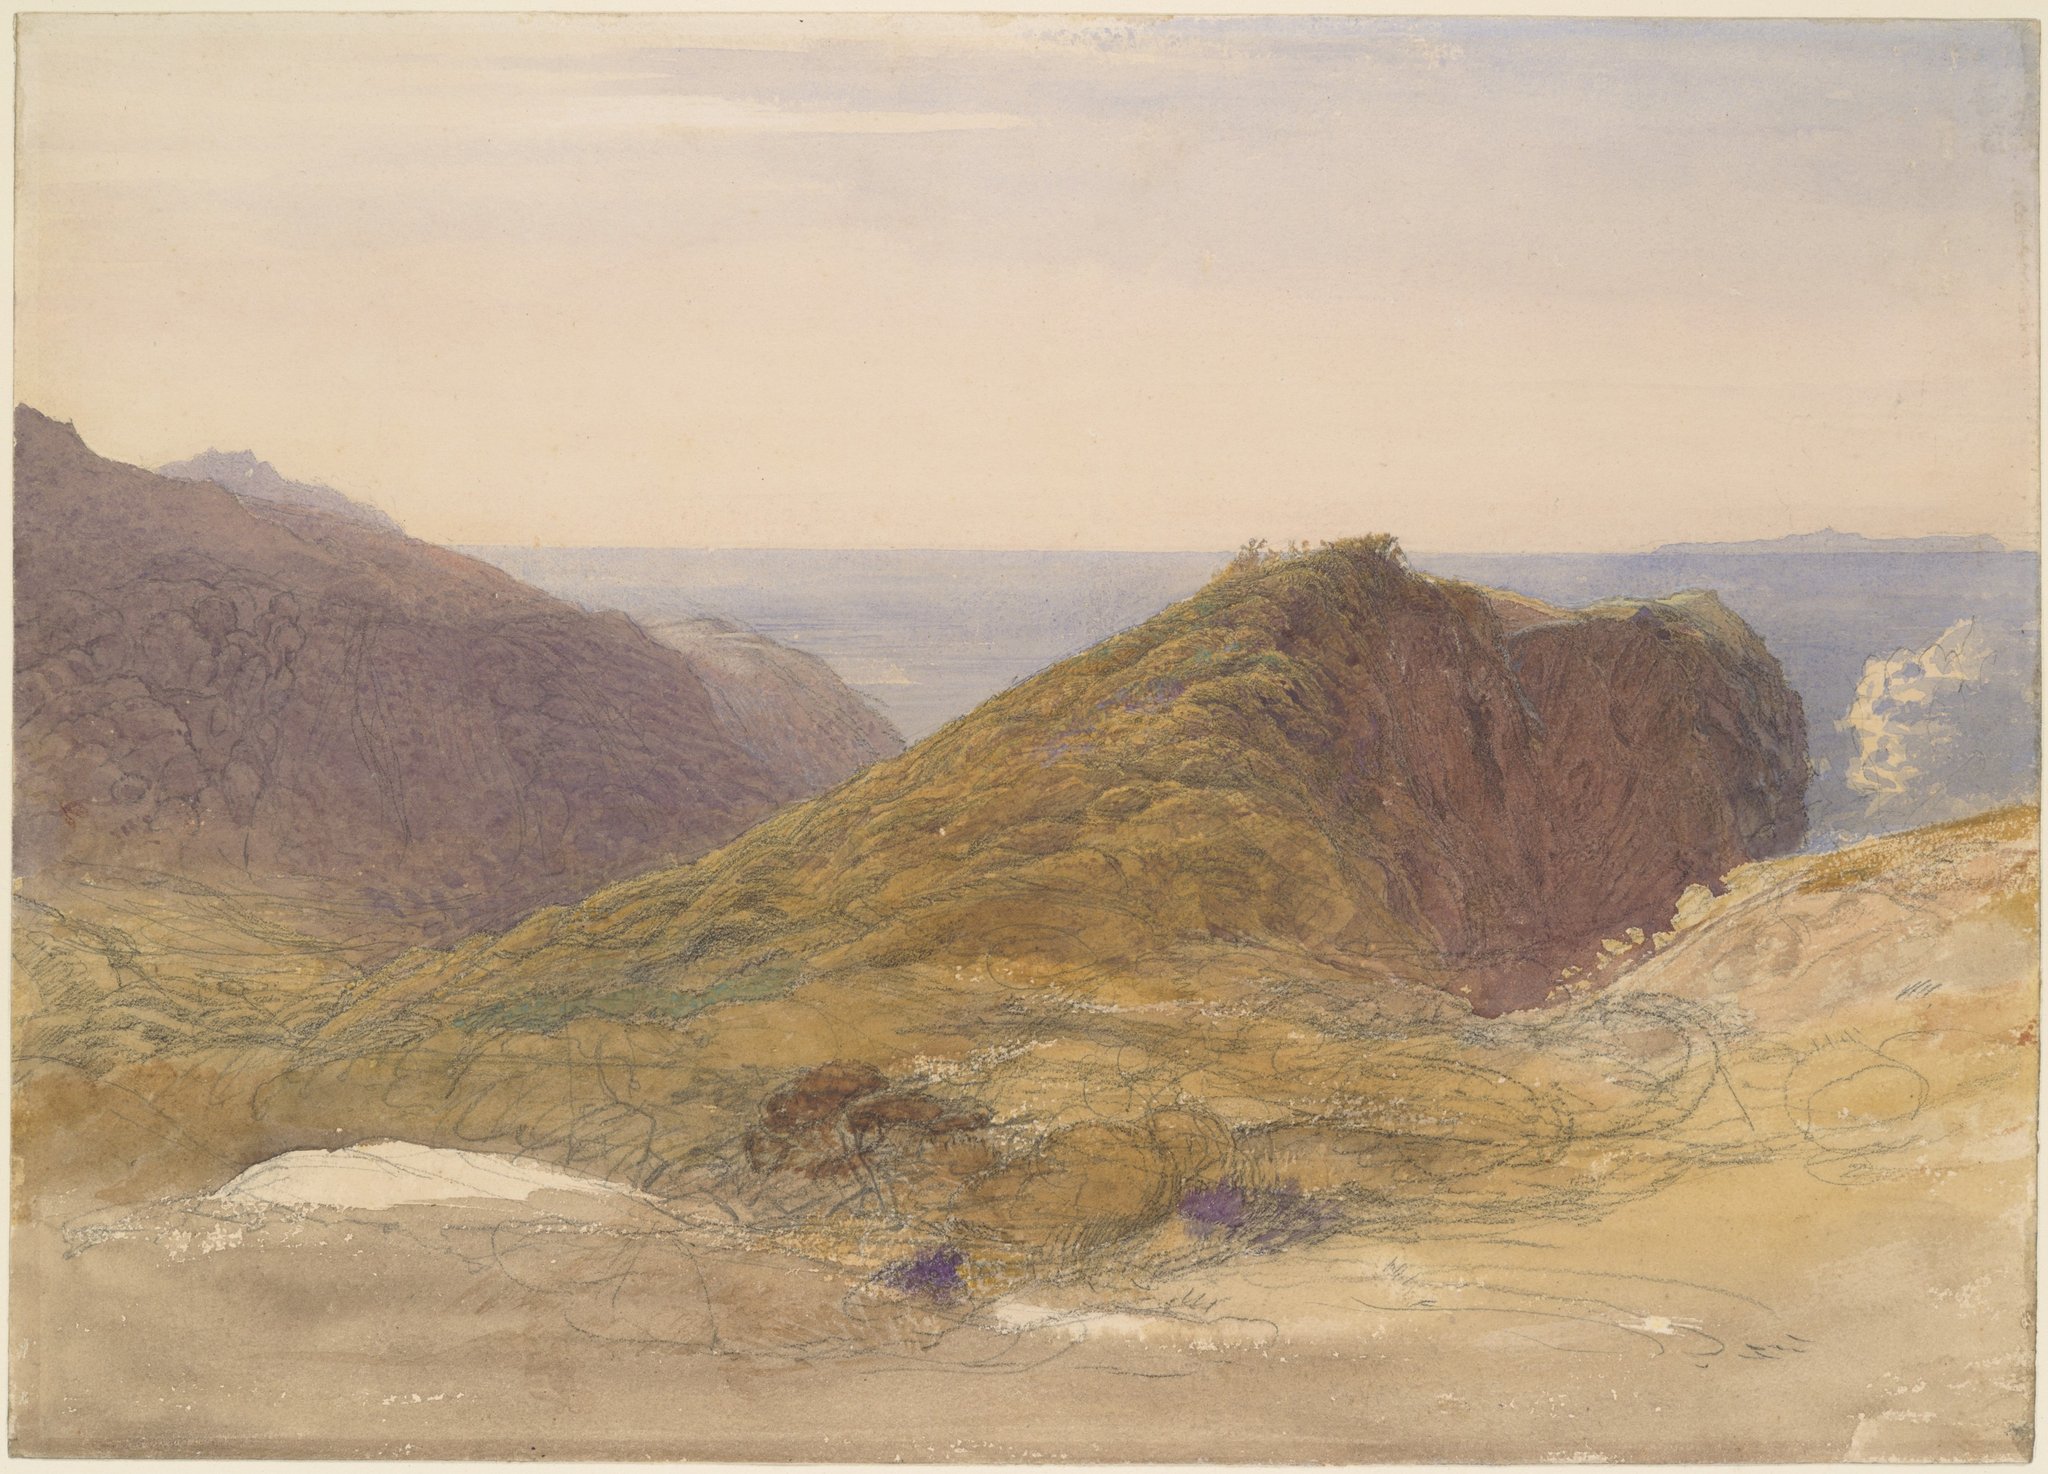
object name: drawing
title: On the North Coast of Devon, Lundy Island in the Distance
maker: samuel palmer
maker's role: artist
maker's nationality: british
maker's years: 1805-1881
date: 1835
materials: chalk, gouache, graphite, watercolor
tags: hills,landscapes